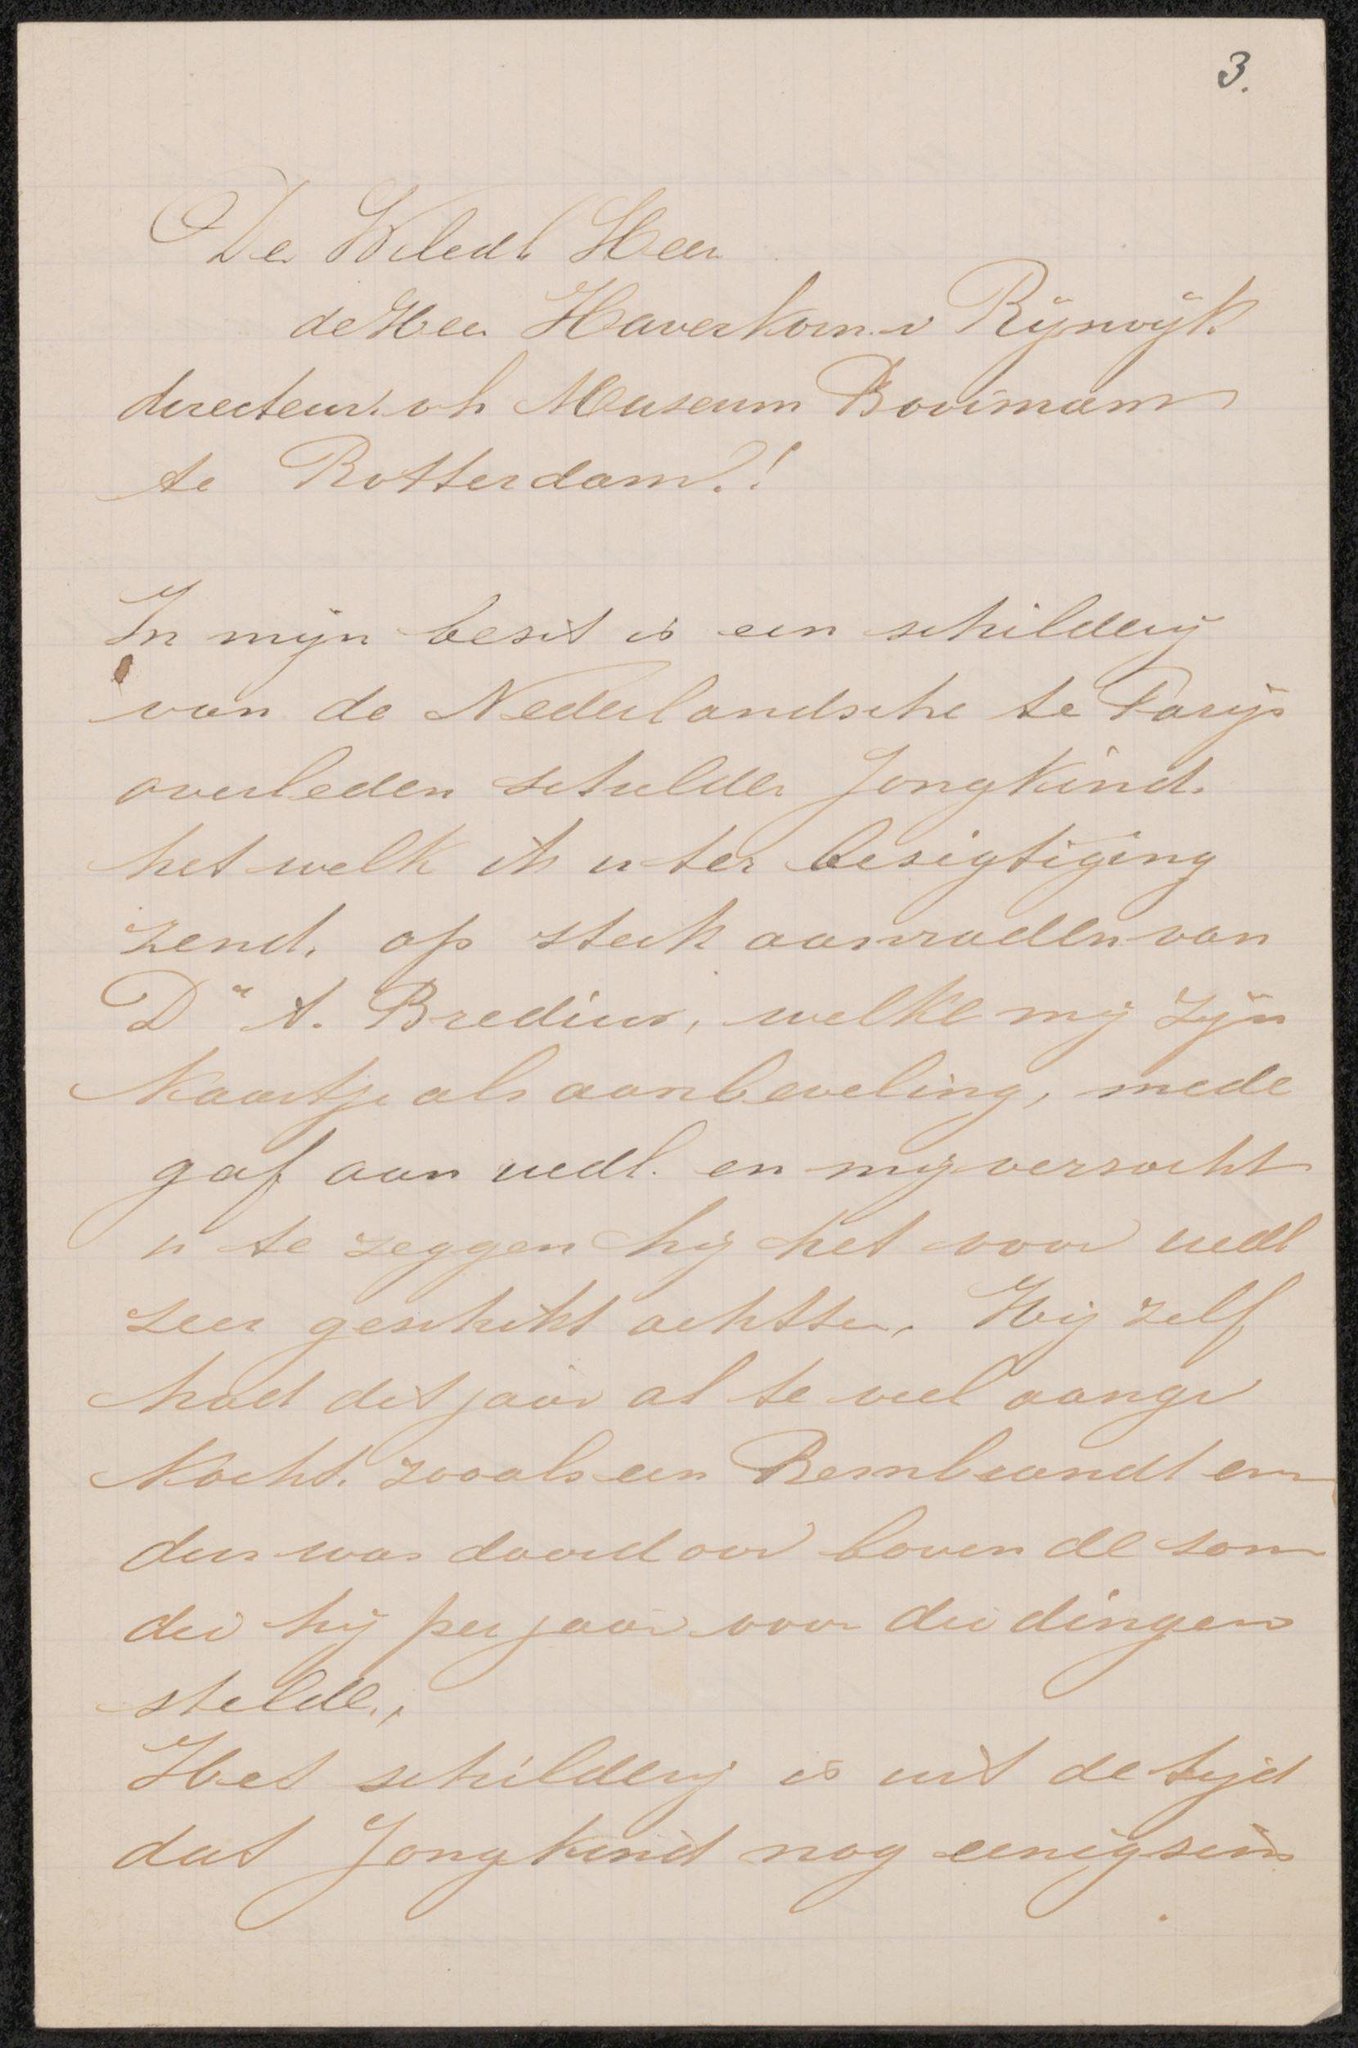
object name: letter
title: Brief aan Pieter Haverkorn van Rijsewijk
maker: corstiaan willem smith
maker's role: painter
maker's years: 1861-1954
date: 1807-1892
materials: ink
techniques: pen, writing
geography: maassluis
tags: painter, print maker, draughtsman, johan barthold jongkind, pieter haverkorn van rijsewijk, amsterdam, abraham bredius, art trade, art shop, painting (including book-illumination, miniature-painting), art collecting, money, paris